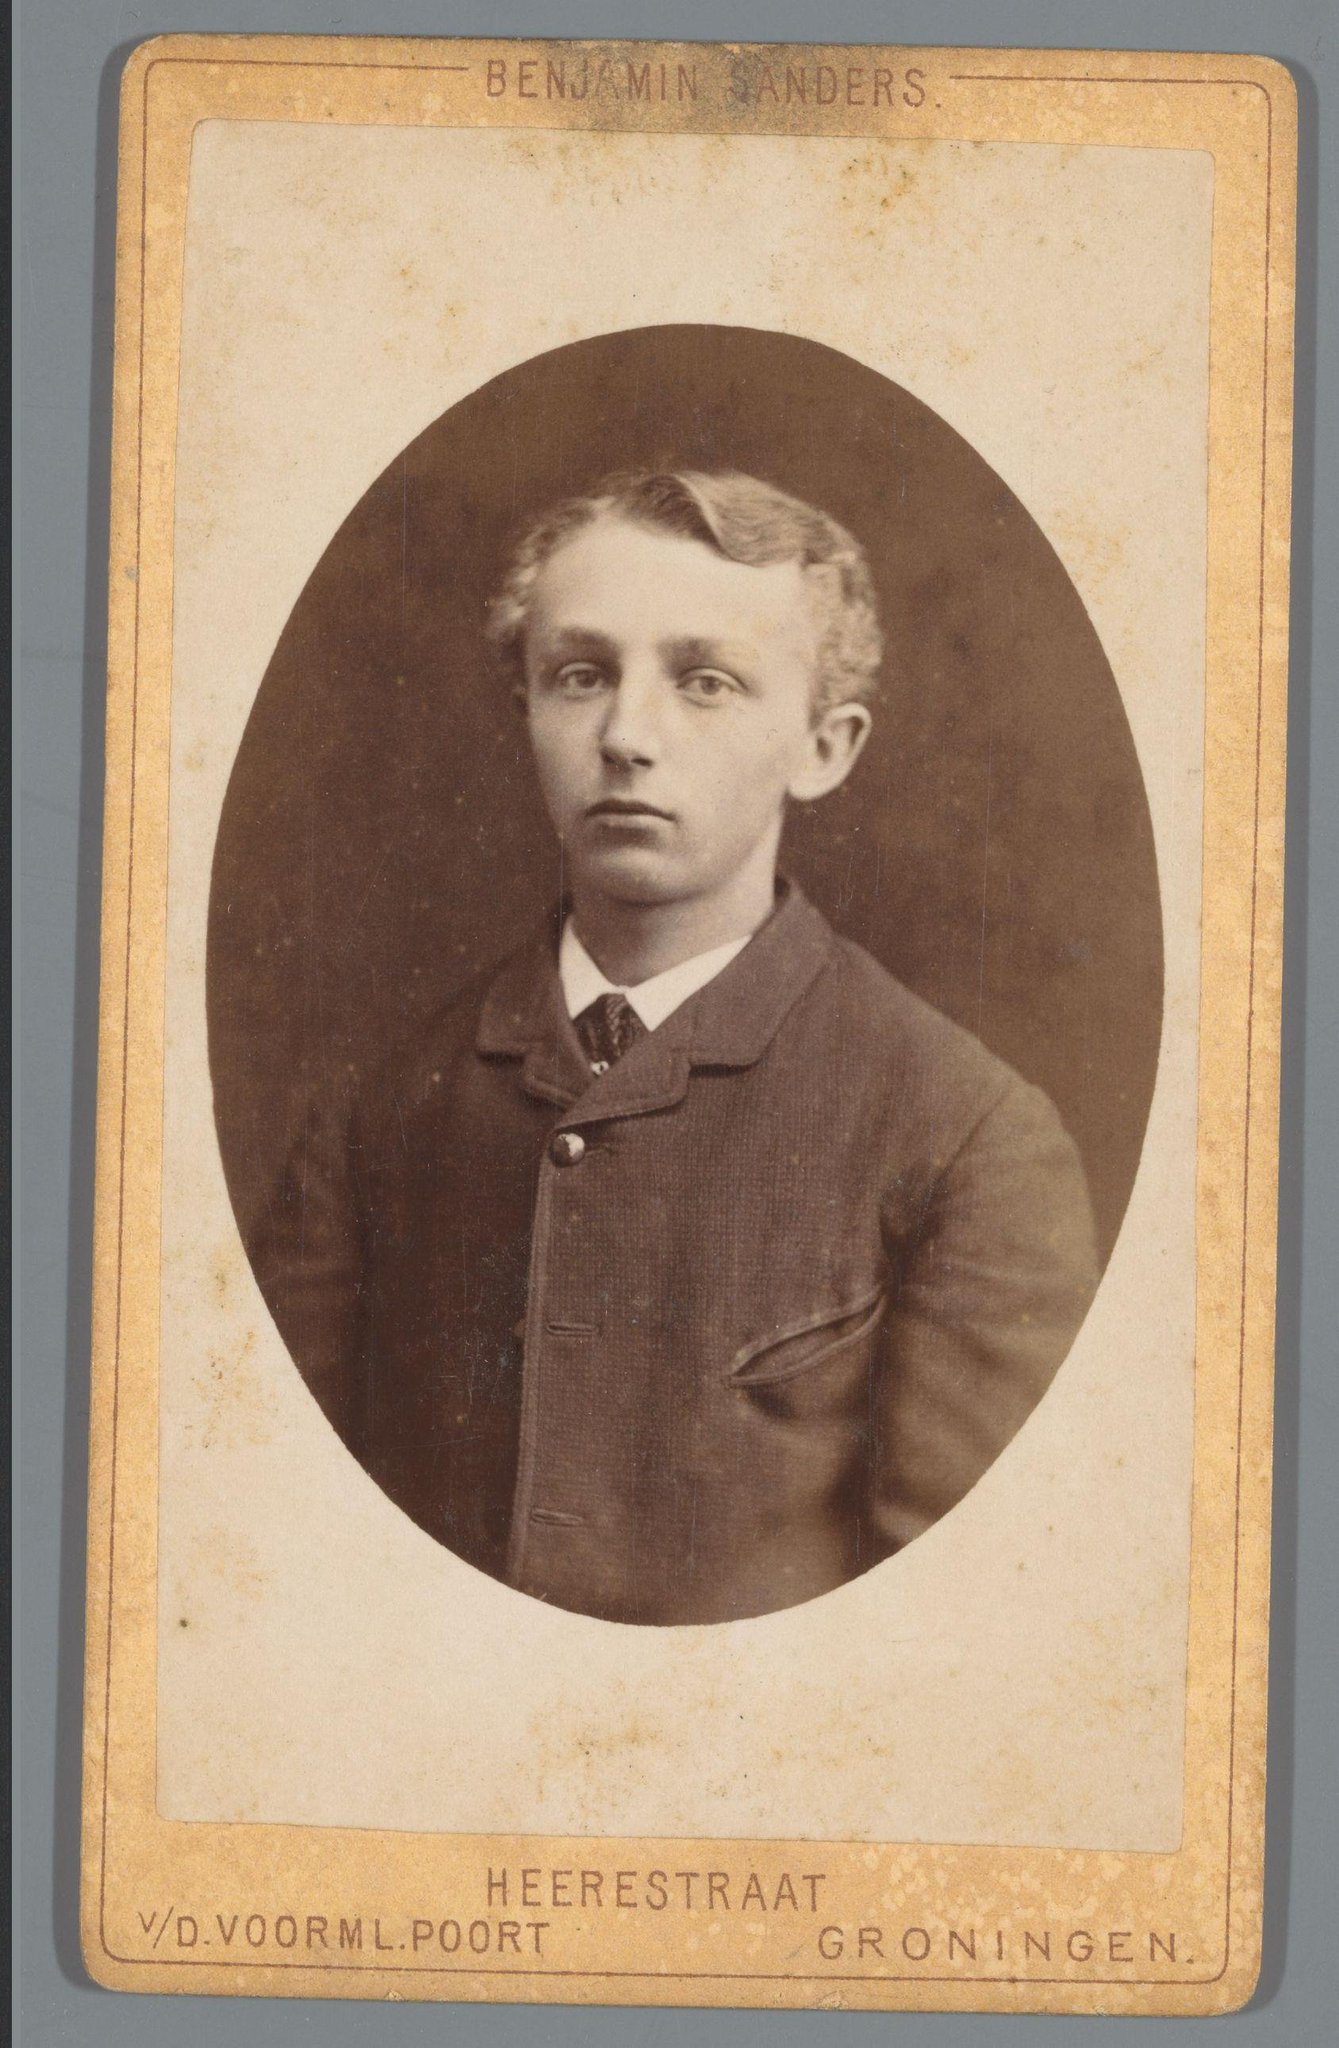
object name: carte de visite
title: Portret van Hiepke Boersma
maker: benjamin sanders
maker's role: fotograaf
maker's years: 1841-1889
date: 1880-1889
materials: cardboard, paper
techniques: albumen print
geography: groningen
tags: historical persons, youth, adolescent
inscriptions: inscription: ‘Hiepke Boersma/ leeraar HBS/ Den Haag’, inscription: ‘Photographisch/ Atelier/ BENJAMIN SANDERS/ GRONINGEN/ Heerestraat v/d voorml. poort R. 514./ VERGROOTINGEN/ kunnen naar ieder portret vervaardigt worden./ De plaat blijft tot nabestelling bewaard.’